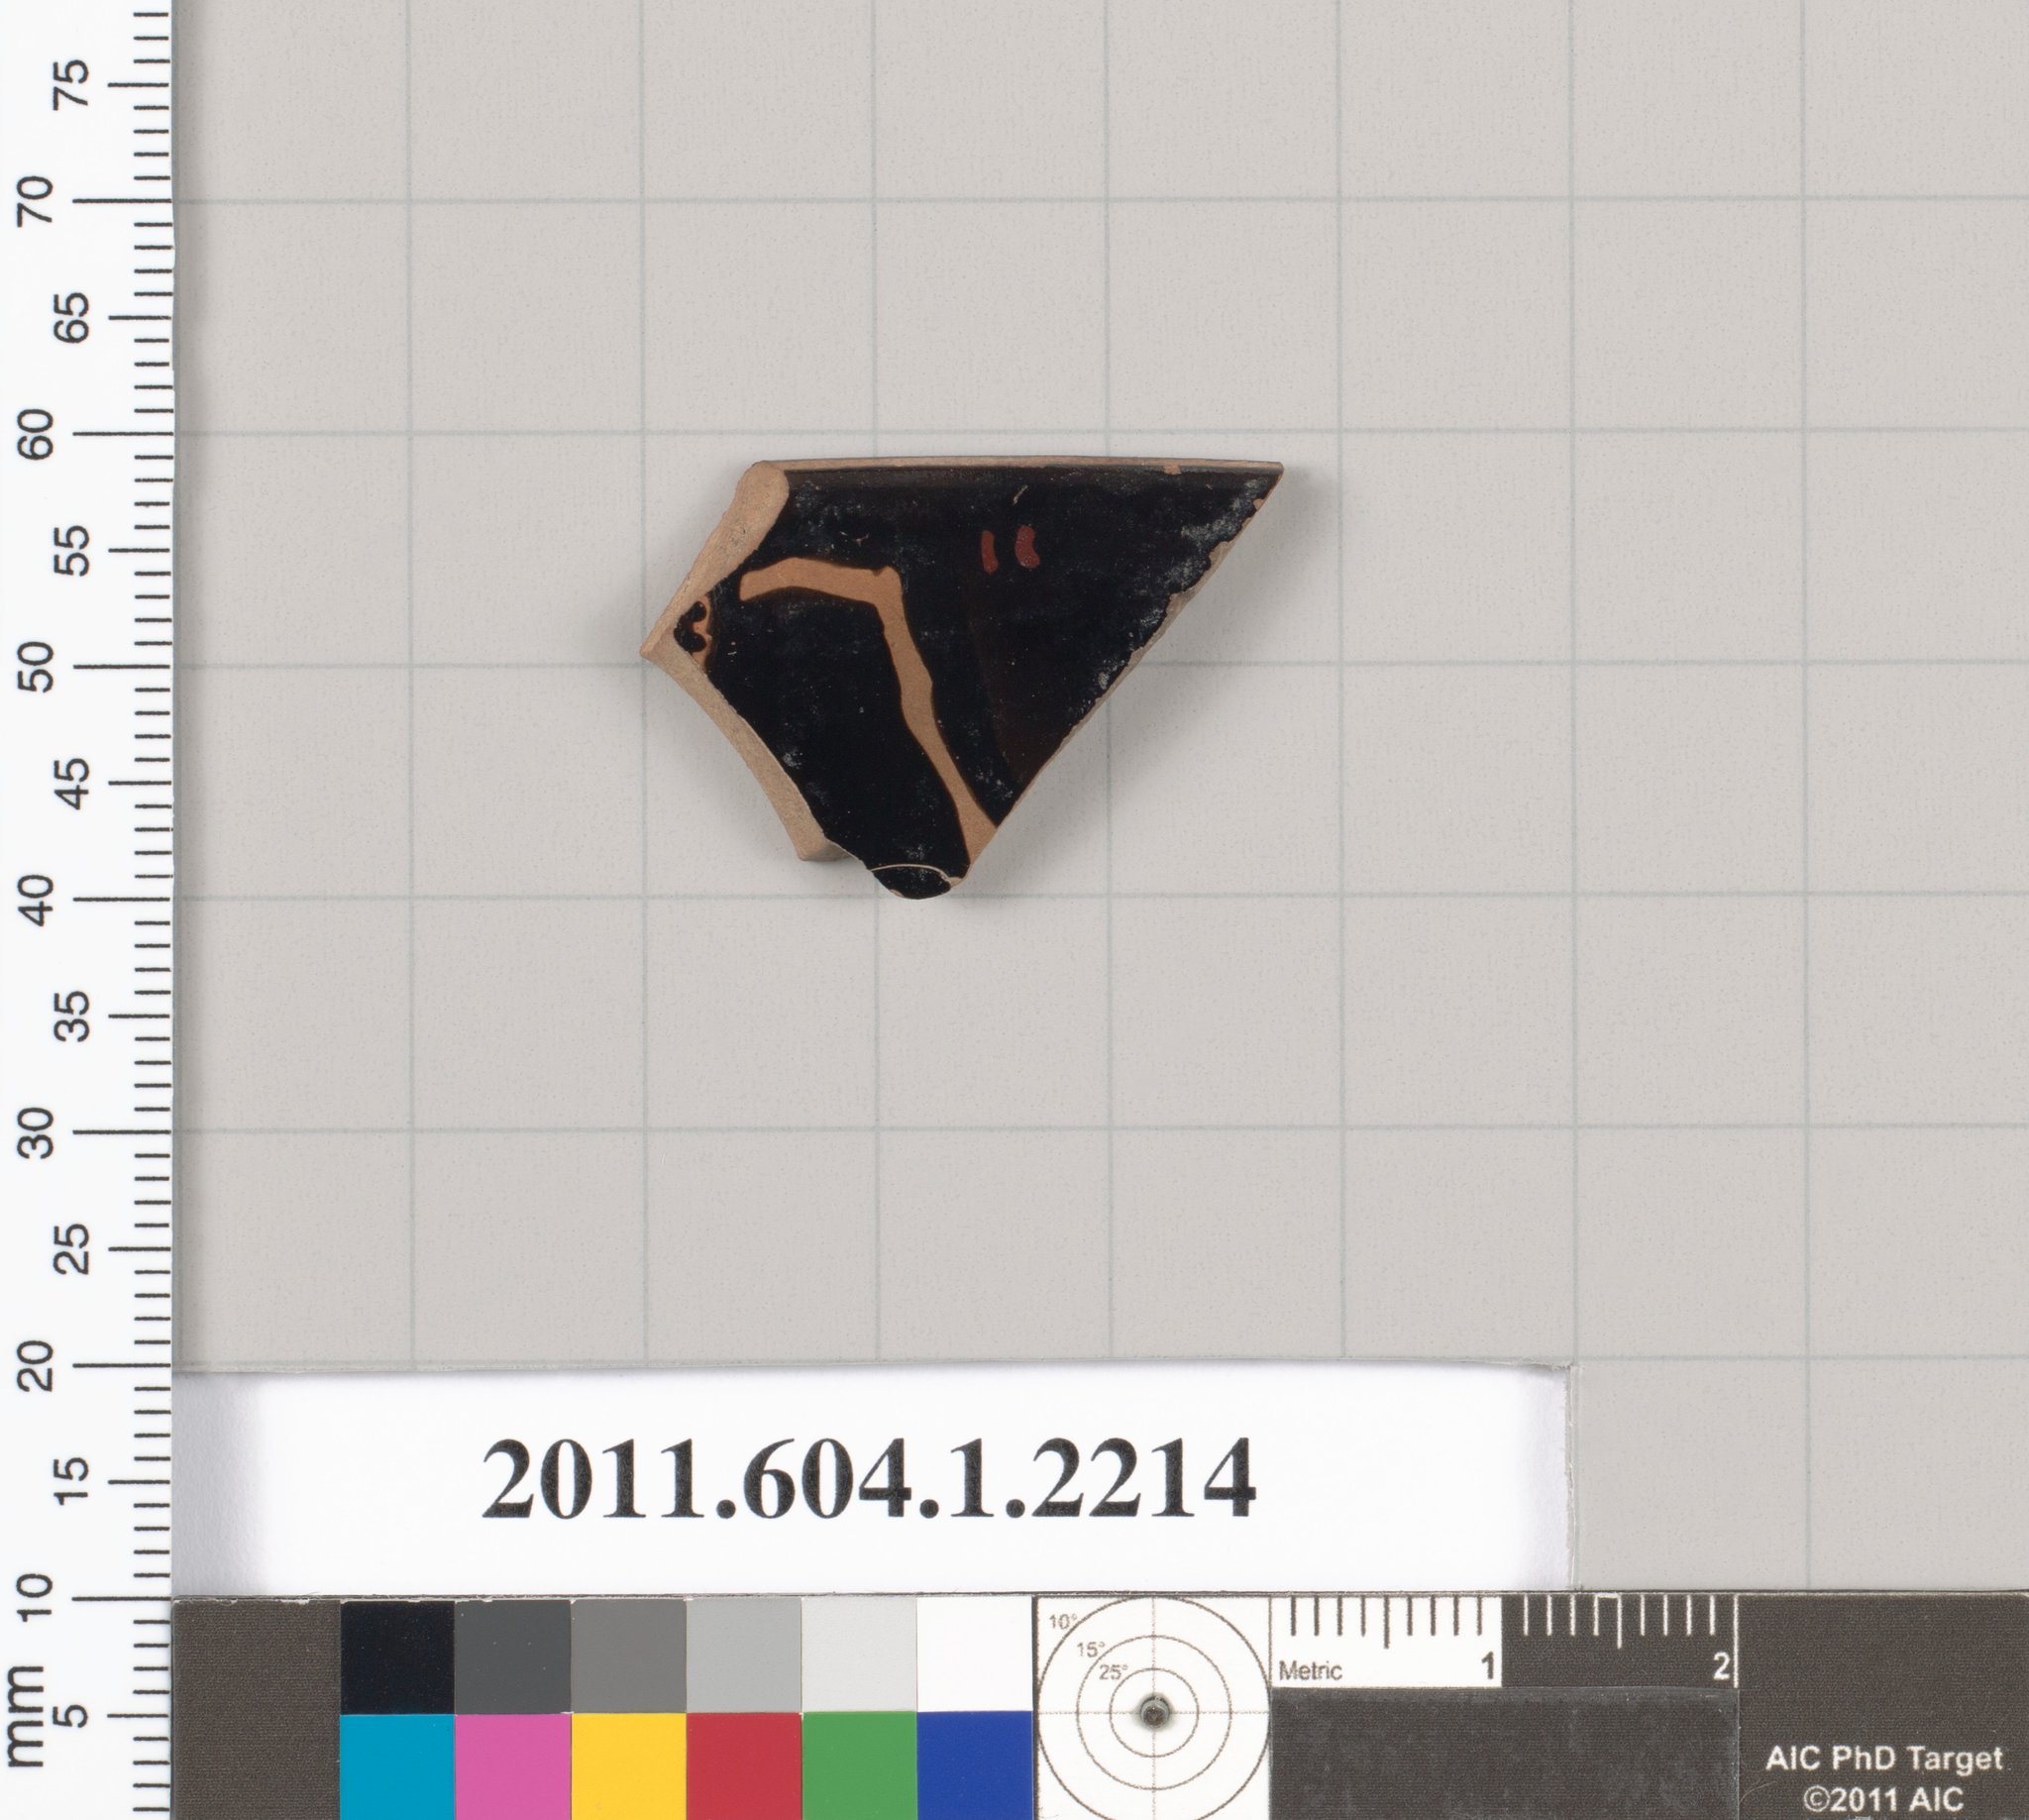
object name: kylix fragment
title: Terracotta rim fragment of a kylix (drinking cup)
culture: greek, attic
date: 475-451 BCE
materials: terracotta